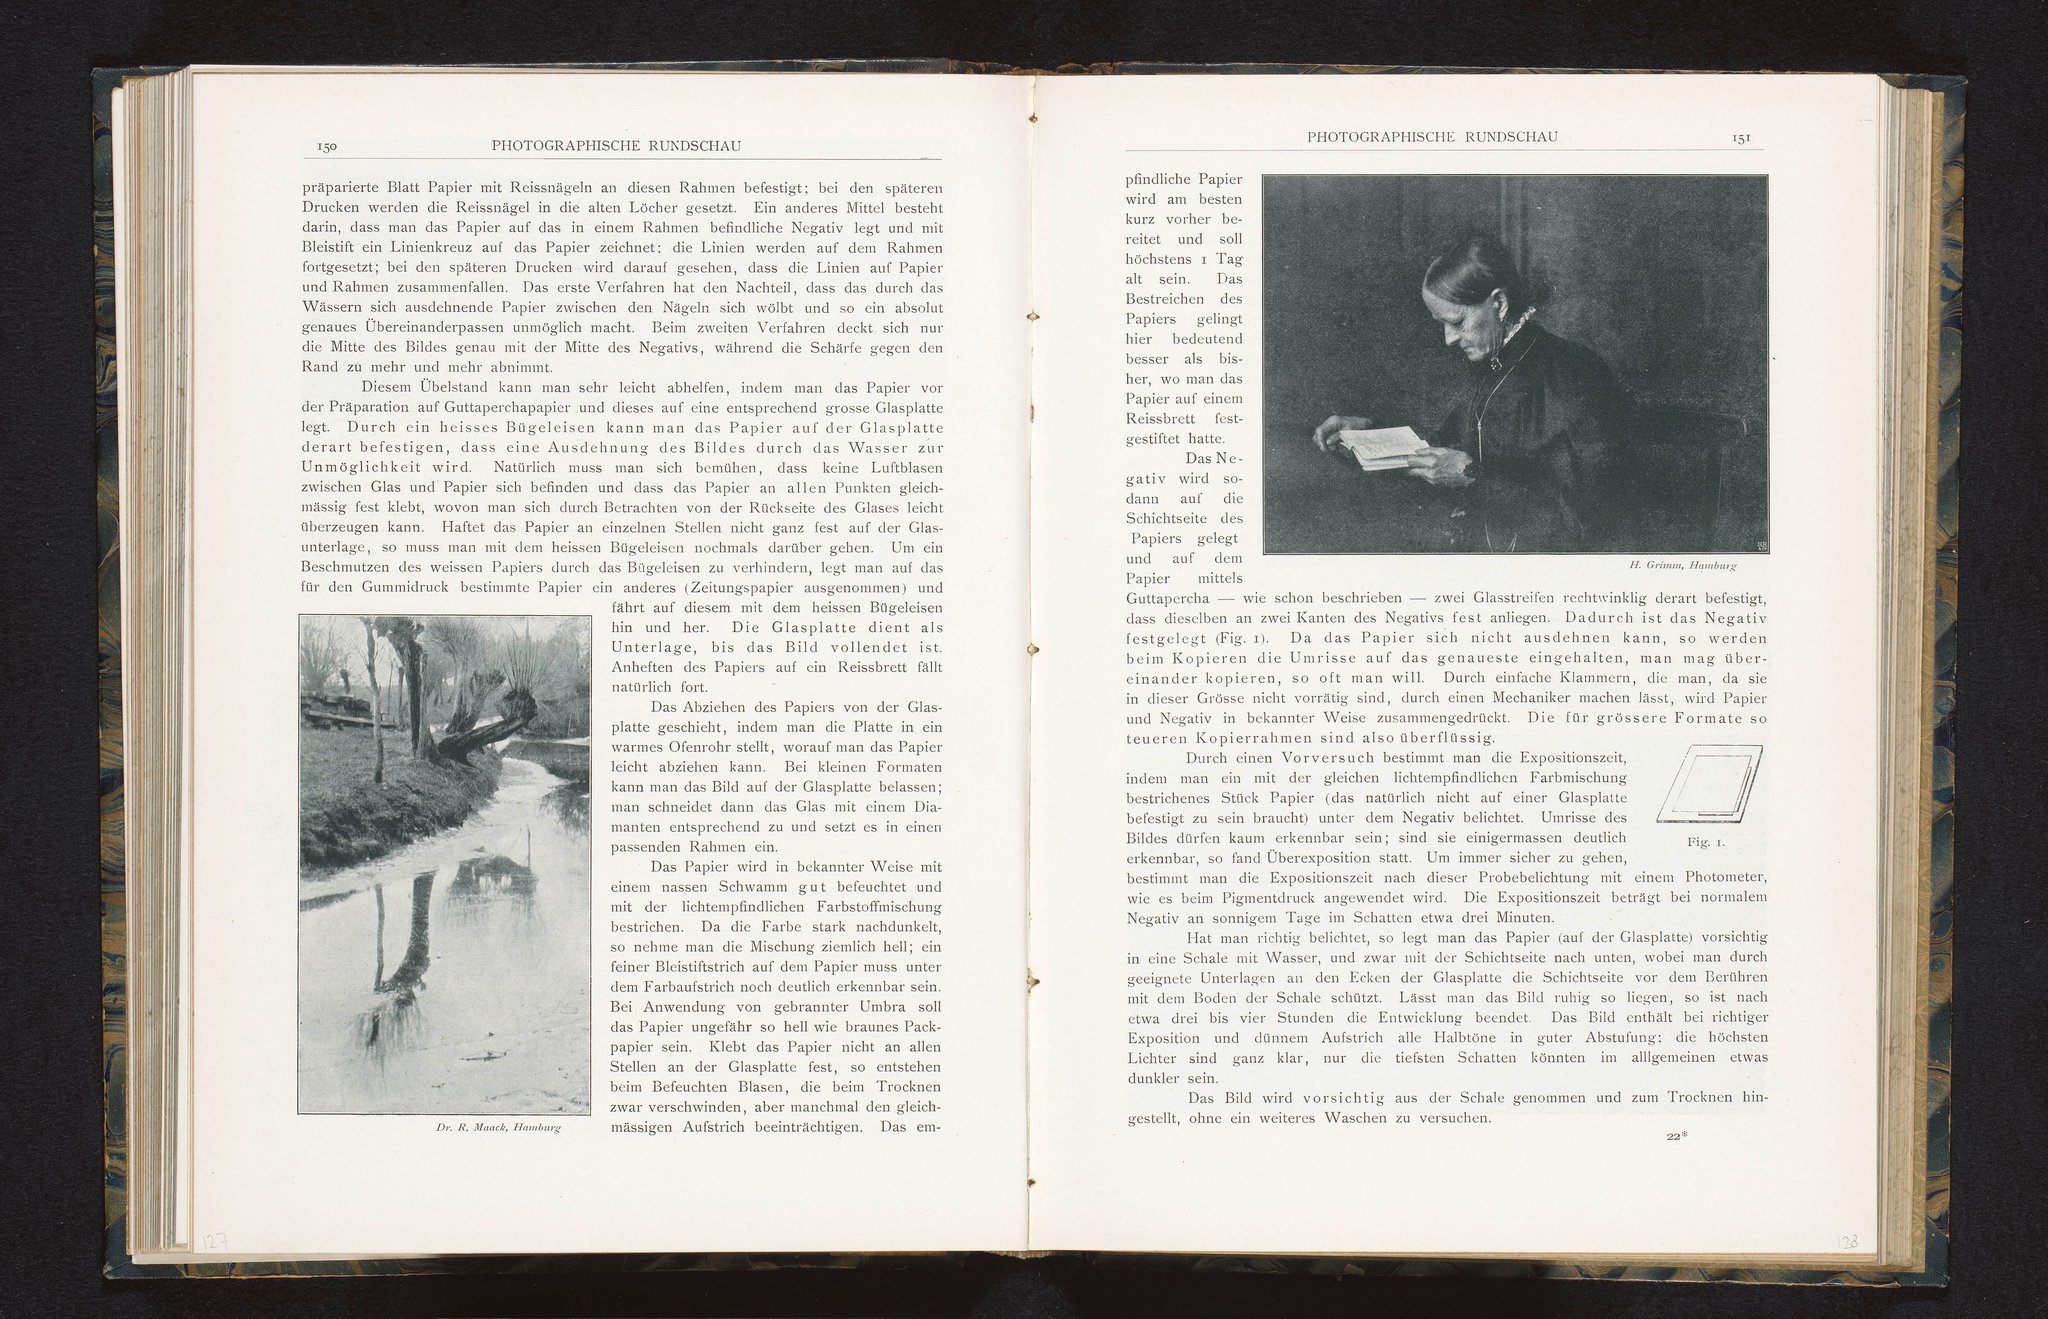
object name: page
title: Gezicht op een sloot met daarlangs bomen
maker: dr. r. maack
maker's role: fotograaf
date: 1895-1900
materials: paper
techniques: autotype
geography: berlin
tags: trees, small canal, ditch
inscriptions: monogram: ‘MR/&Co’